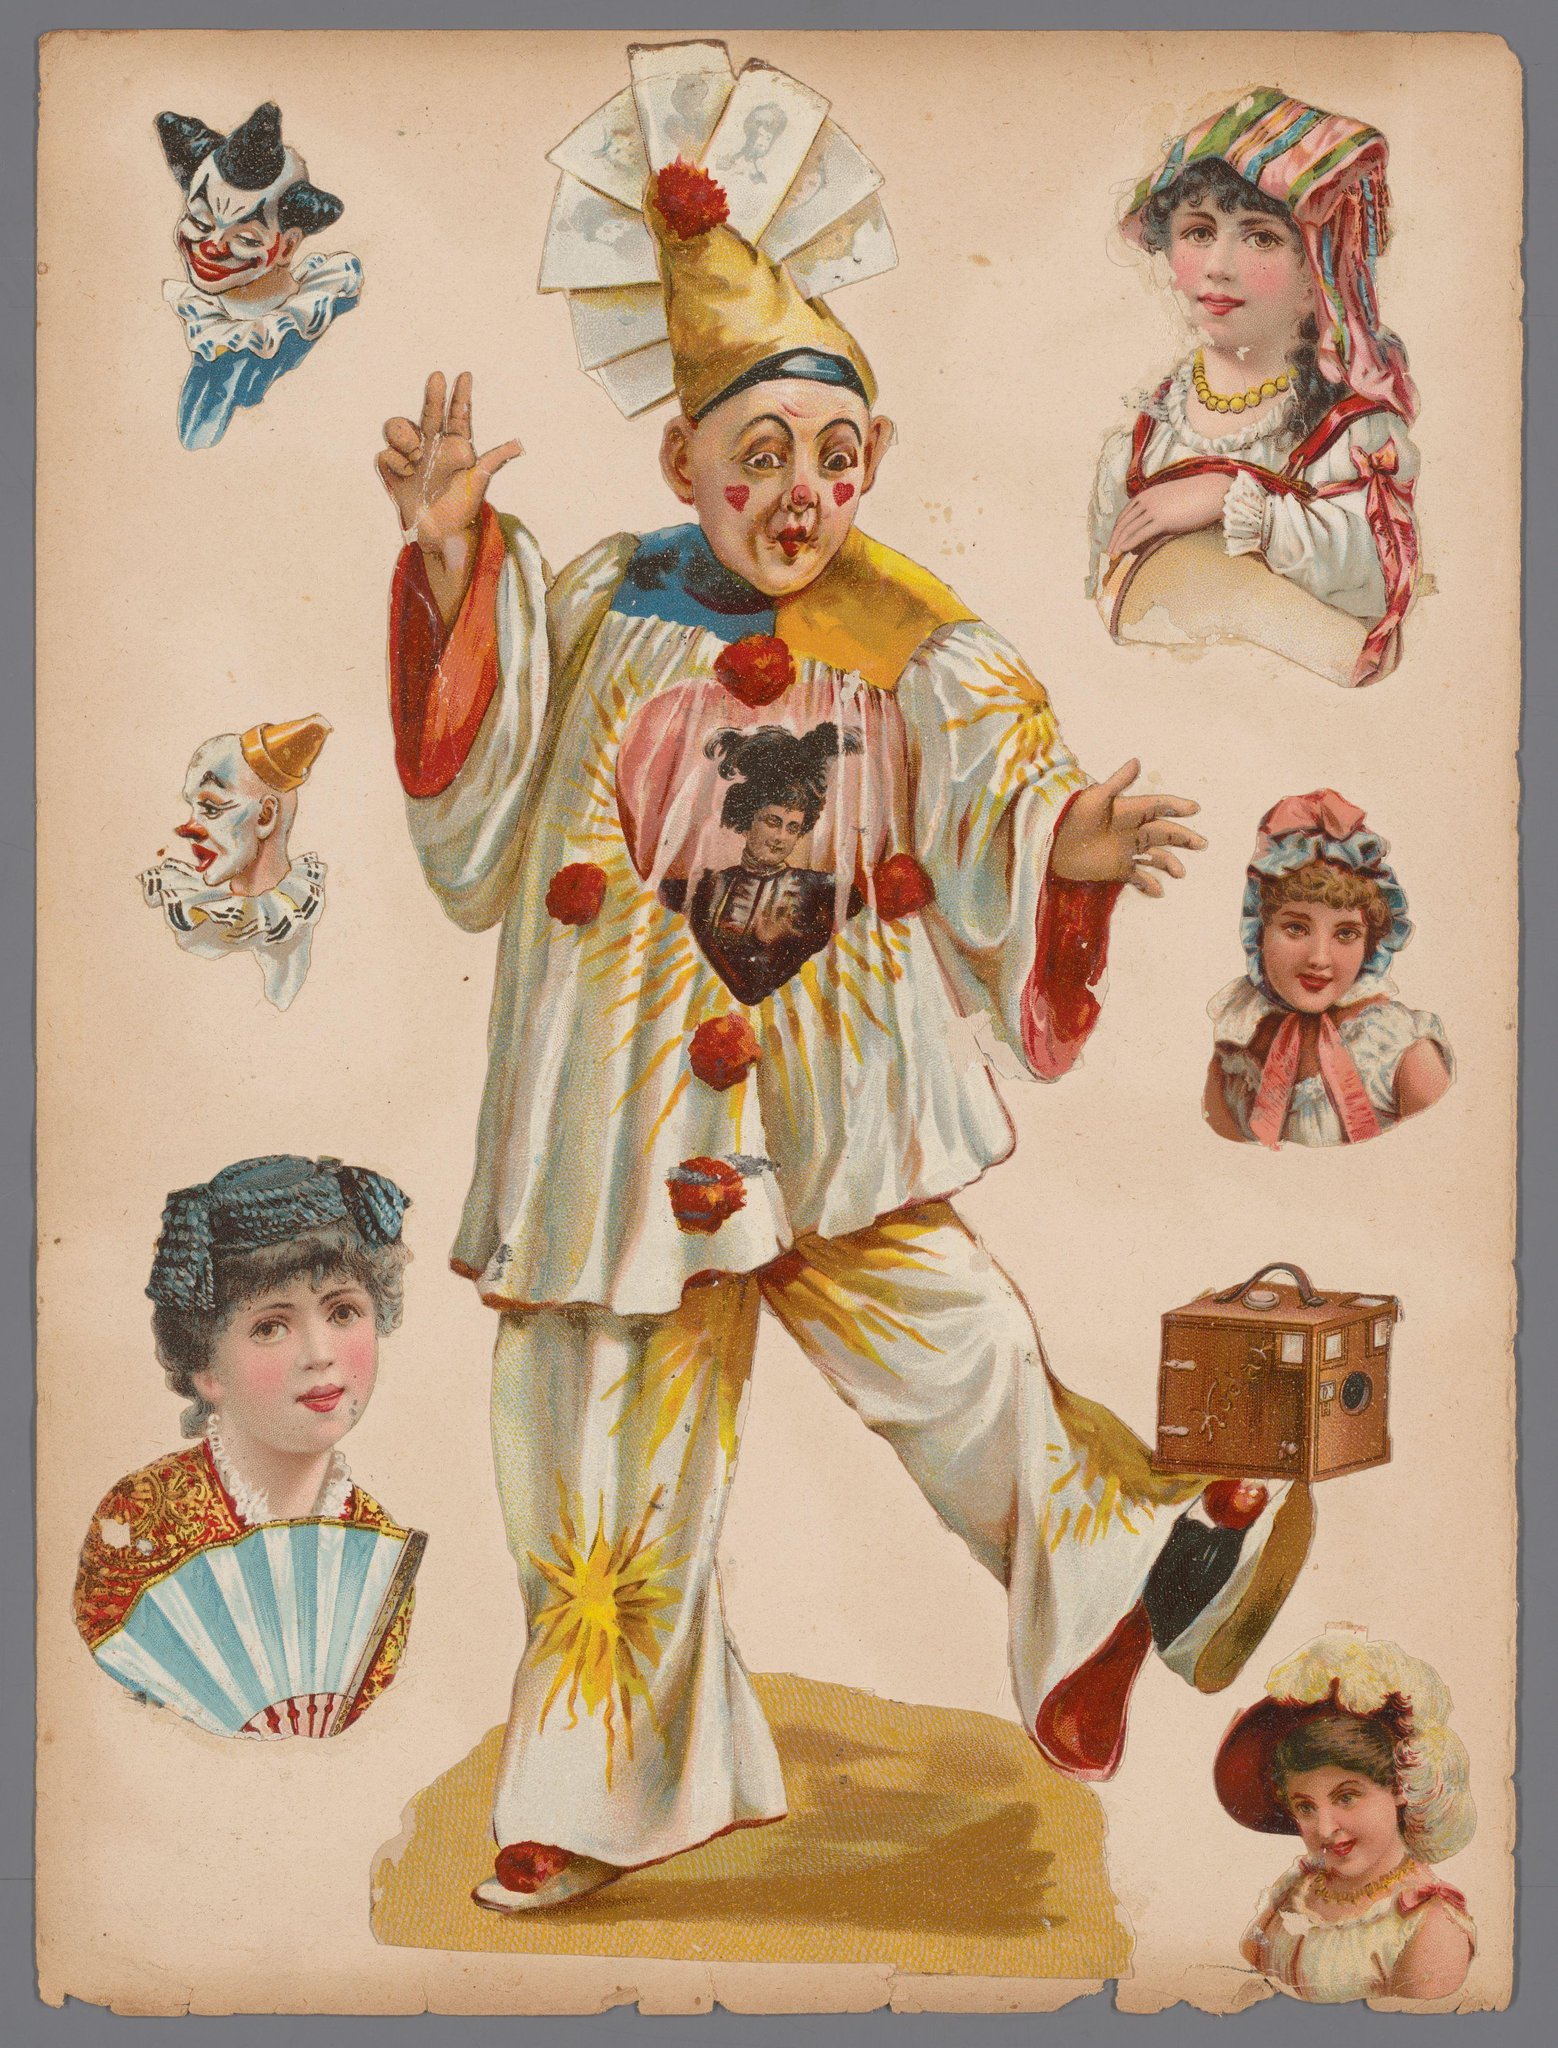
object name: print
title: Blad met opgeplakte poëzieplaatjes, waaronder een clown met Kodak camera op zijn voet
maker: Anonymous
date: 1910-1930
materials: paper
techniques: lithograph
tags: adolescent, young woman, maiden, camera ~ photography, clown, water-birds: duck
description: Zeven plaatjes op recto, van drie clowns en vier jonge vrouwen; tien plaatjes op verso van eenden.